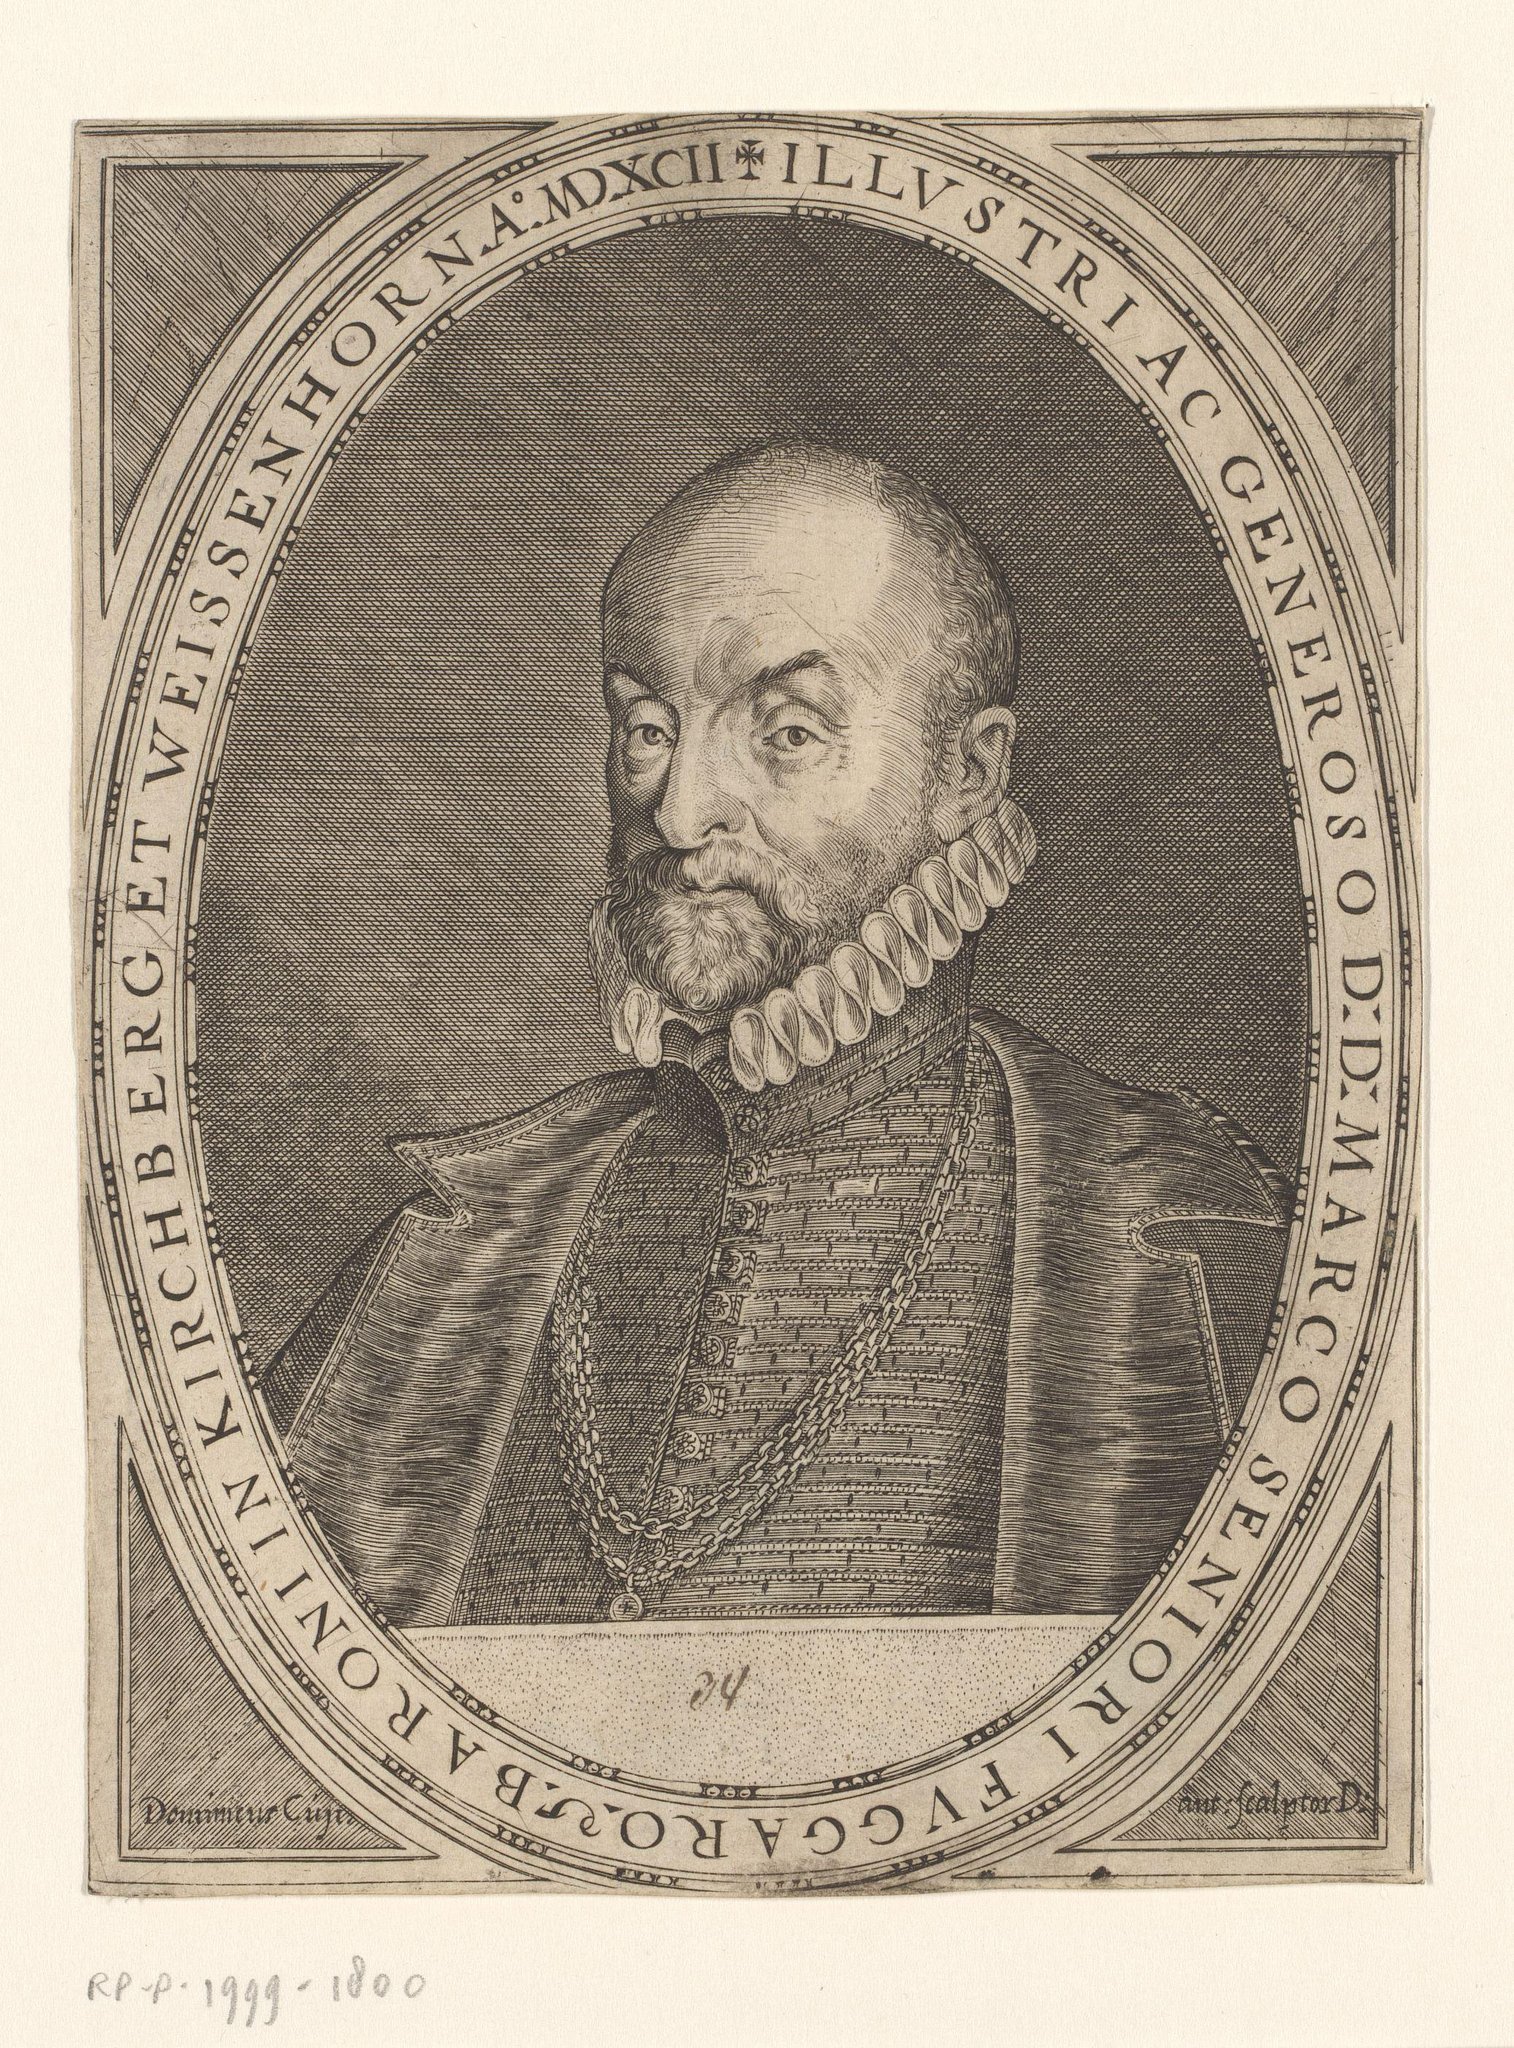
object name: print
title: Portret Marcus Fugger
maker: dominicus custos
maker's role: print maker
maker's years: 1560-1615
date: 1552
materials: paper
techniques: engraving